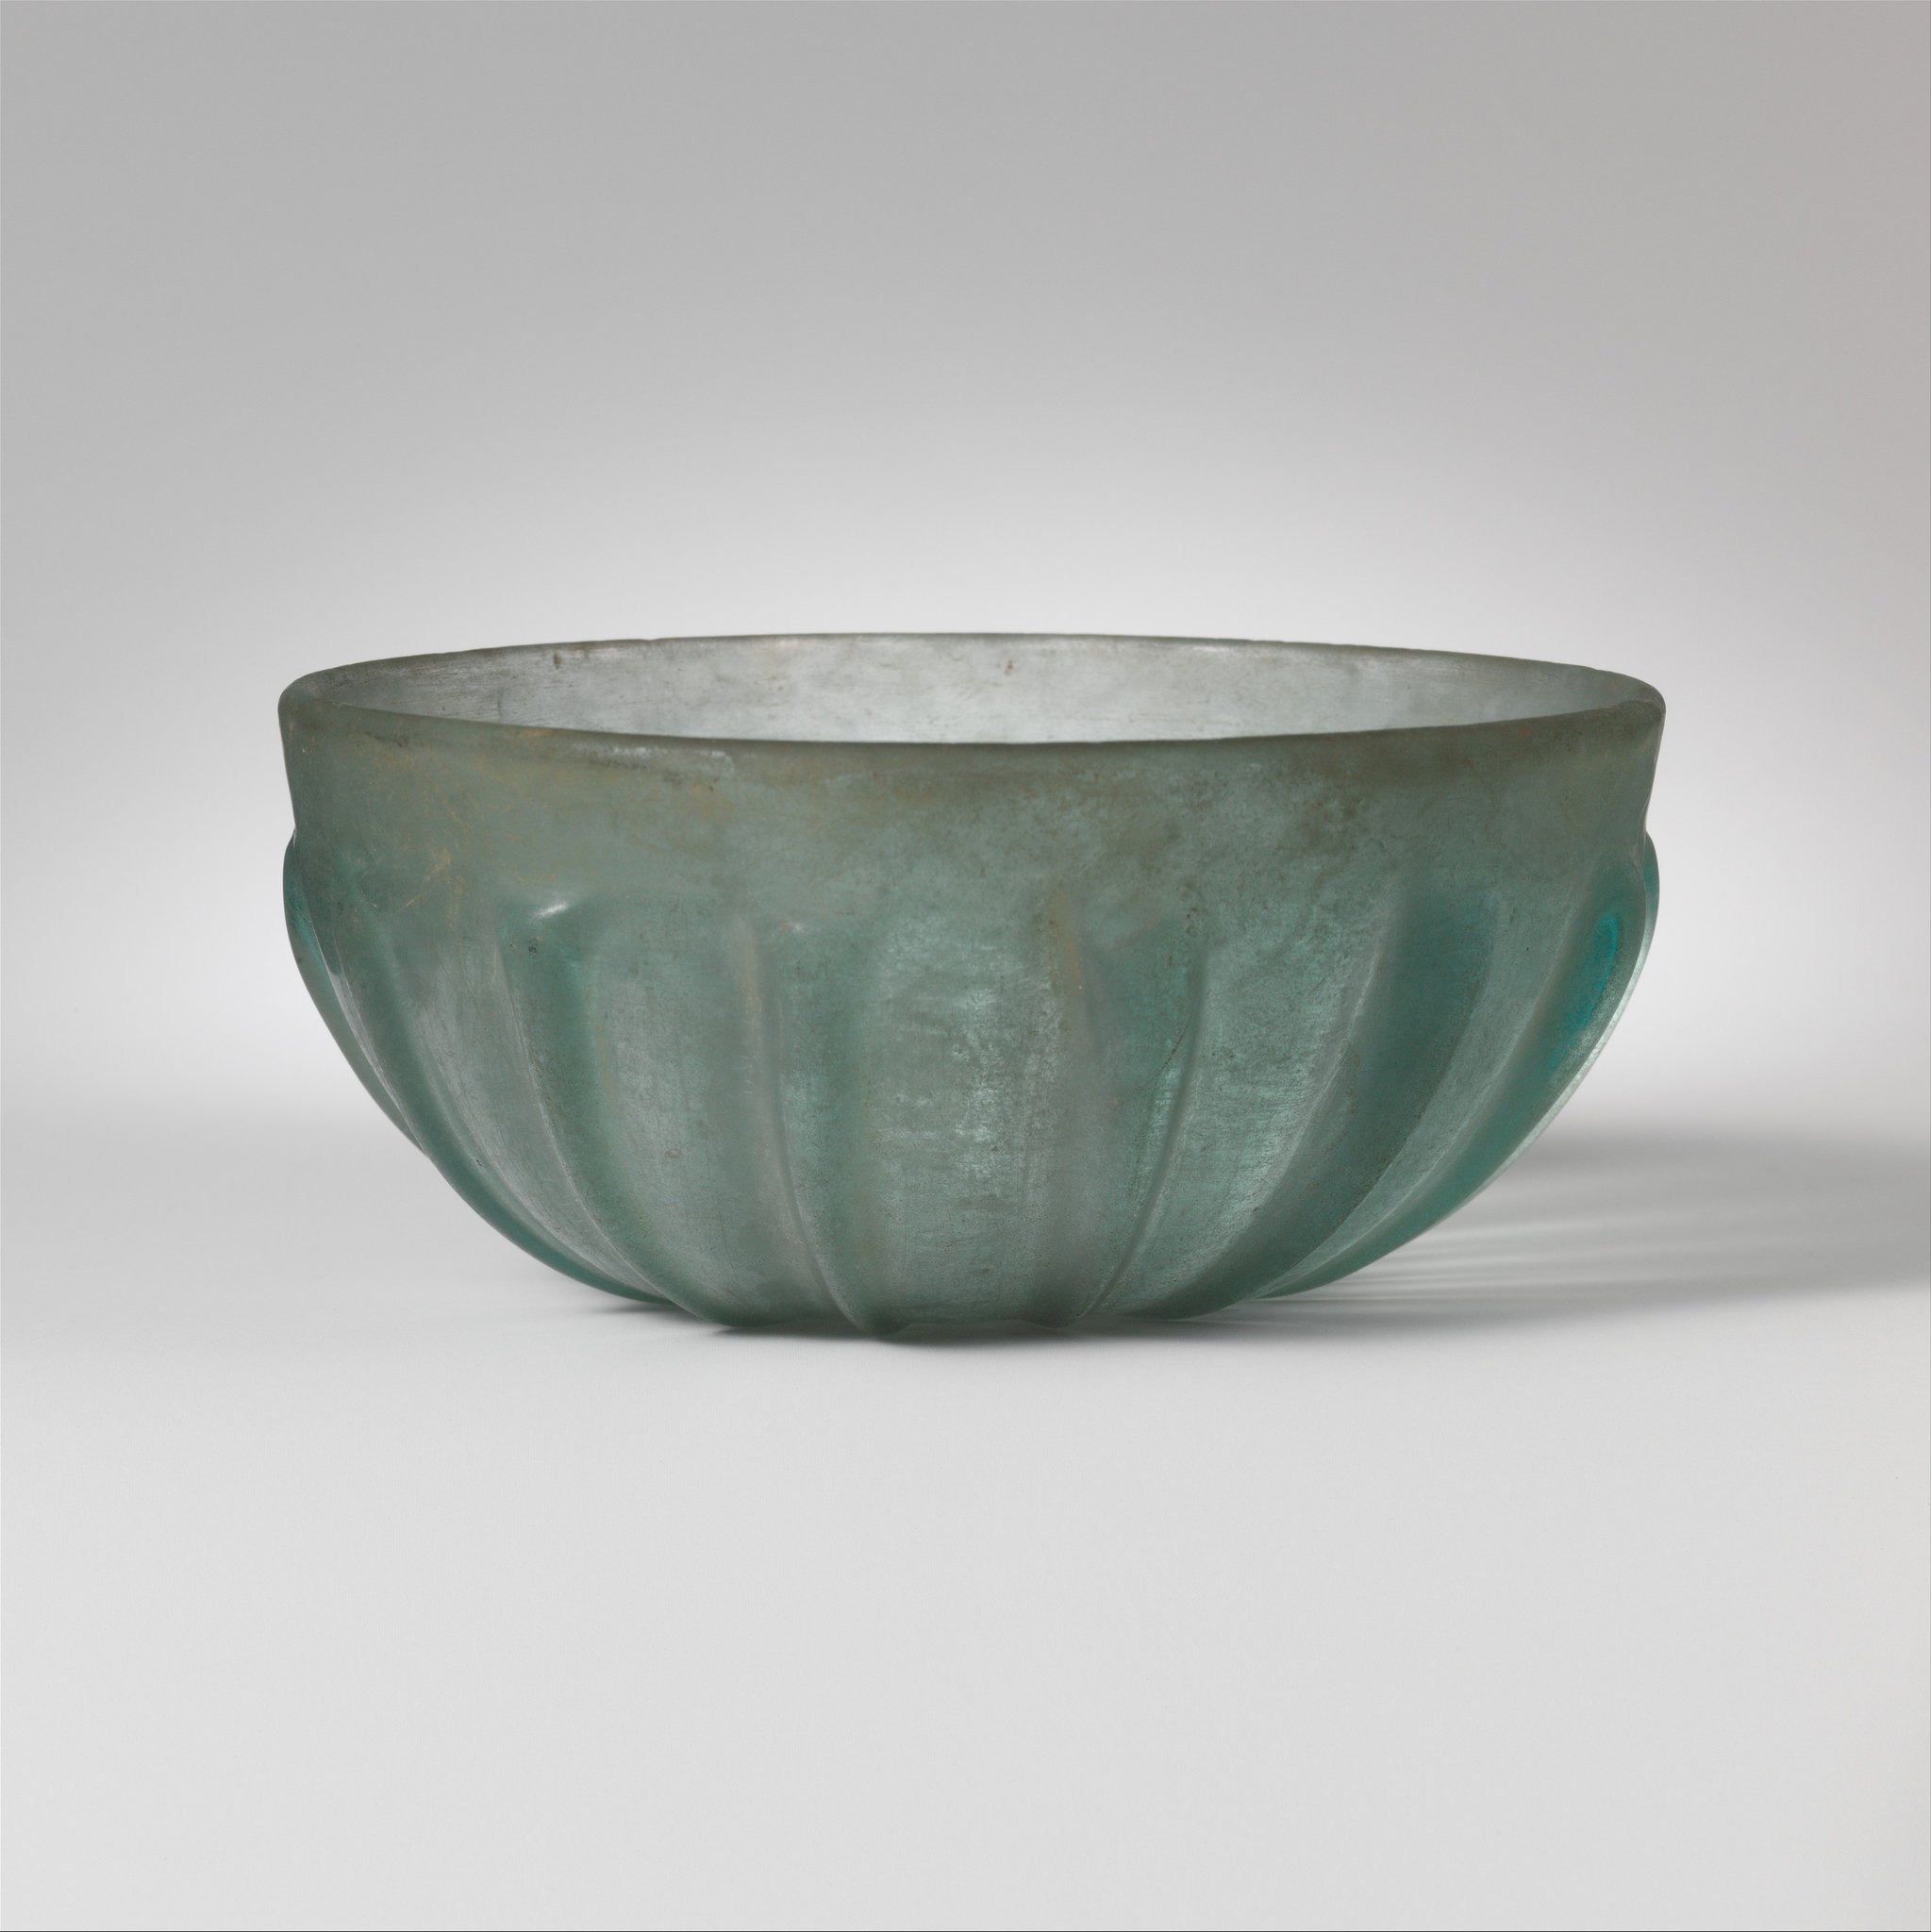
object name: bowl, ribbed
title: Glass ribbed bowl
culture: roman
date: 1-100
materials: glass